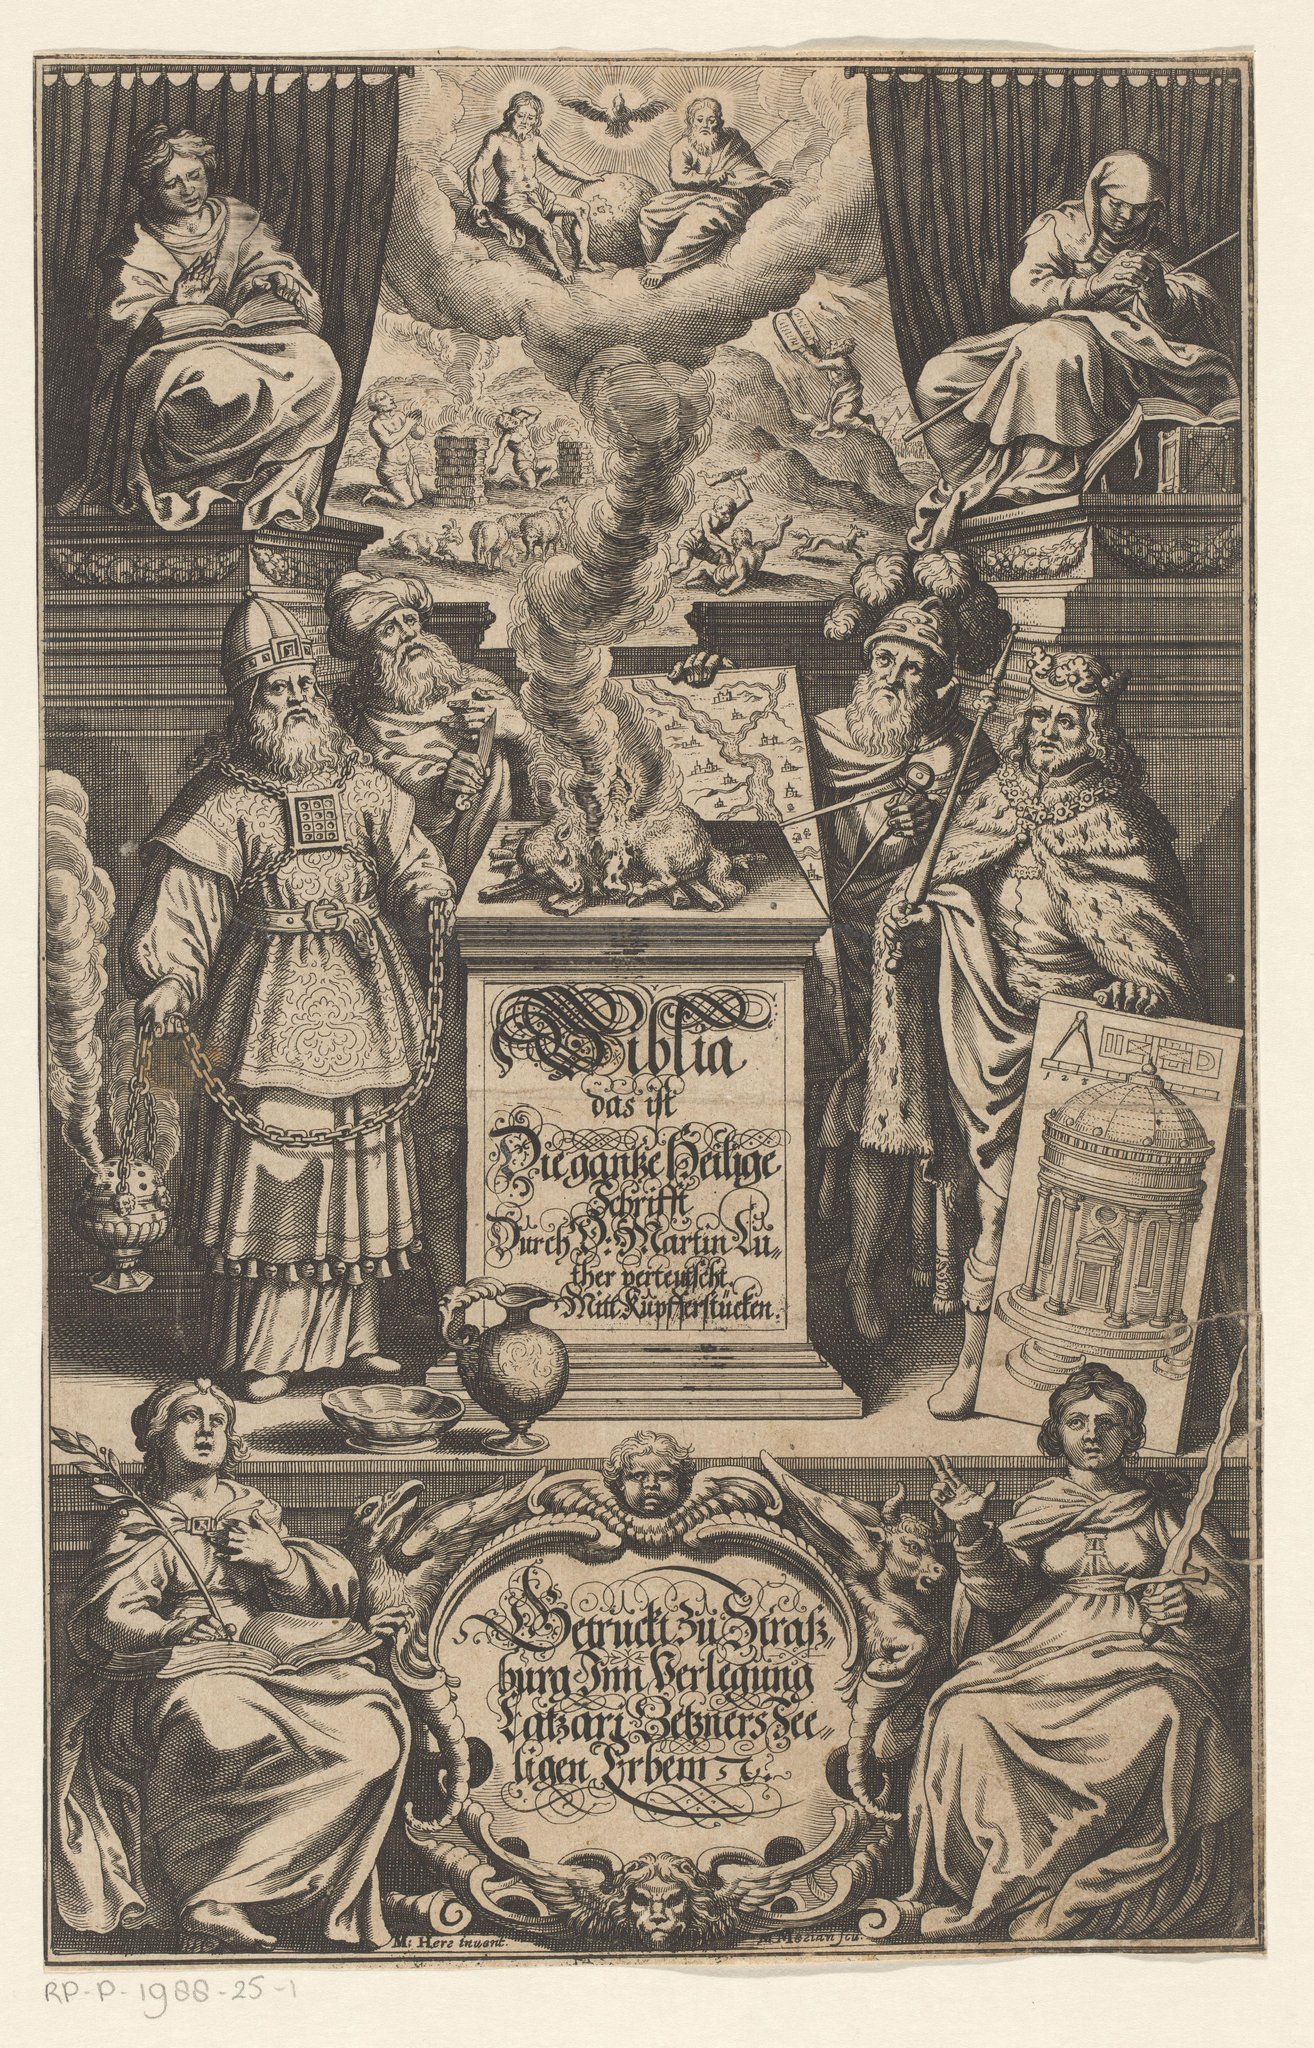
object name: titelblad, titelpagina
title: Offer van een lam door vier mannen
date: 1630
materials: paper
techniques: engraving, etching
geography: straatsburg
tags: offering; 'offerta overo oblatione' (ripa), trinity in which god the father and christ are represented as persons, the holy ghost as dove, the story of cain and abel (genesis 4:3-17)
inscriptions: collector's mark: Lugt 2228, collector's mark: Lugt 2760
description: Een man met wierookvat (mogelijk een priester), een man met tulband, een man met helm en passer en een koning met scepter en tekening van een centraalbouw staan rondom een altaar met titel. Op het altaar wordt het lam geofferd. Boven de rook van het offer zitten Christus, God en de duif als symbool van de heilige geest. In de achtergrond de offers van Kaïn en Abel, de moord van Abel en Mozes met de stenen tafelen. Twee allegorische vrouwenfiguren zittend voor draperieën flankeren de achtergrondscènes. Op de voorgrond zitten een schrijvende vrouw en een vrouw met een zwaard aan weerszijden van een cartouche.